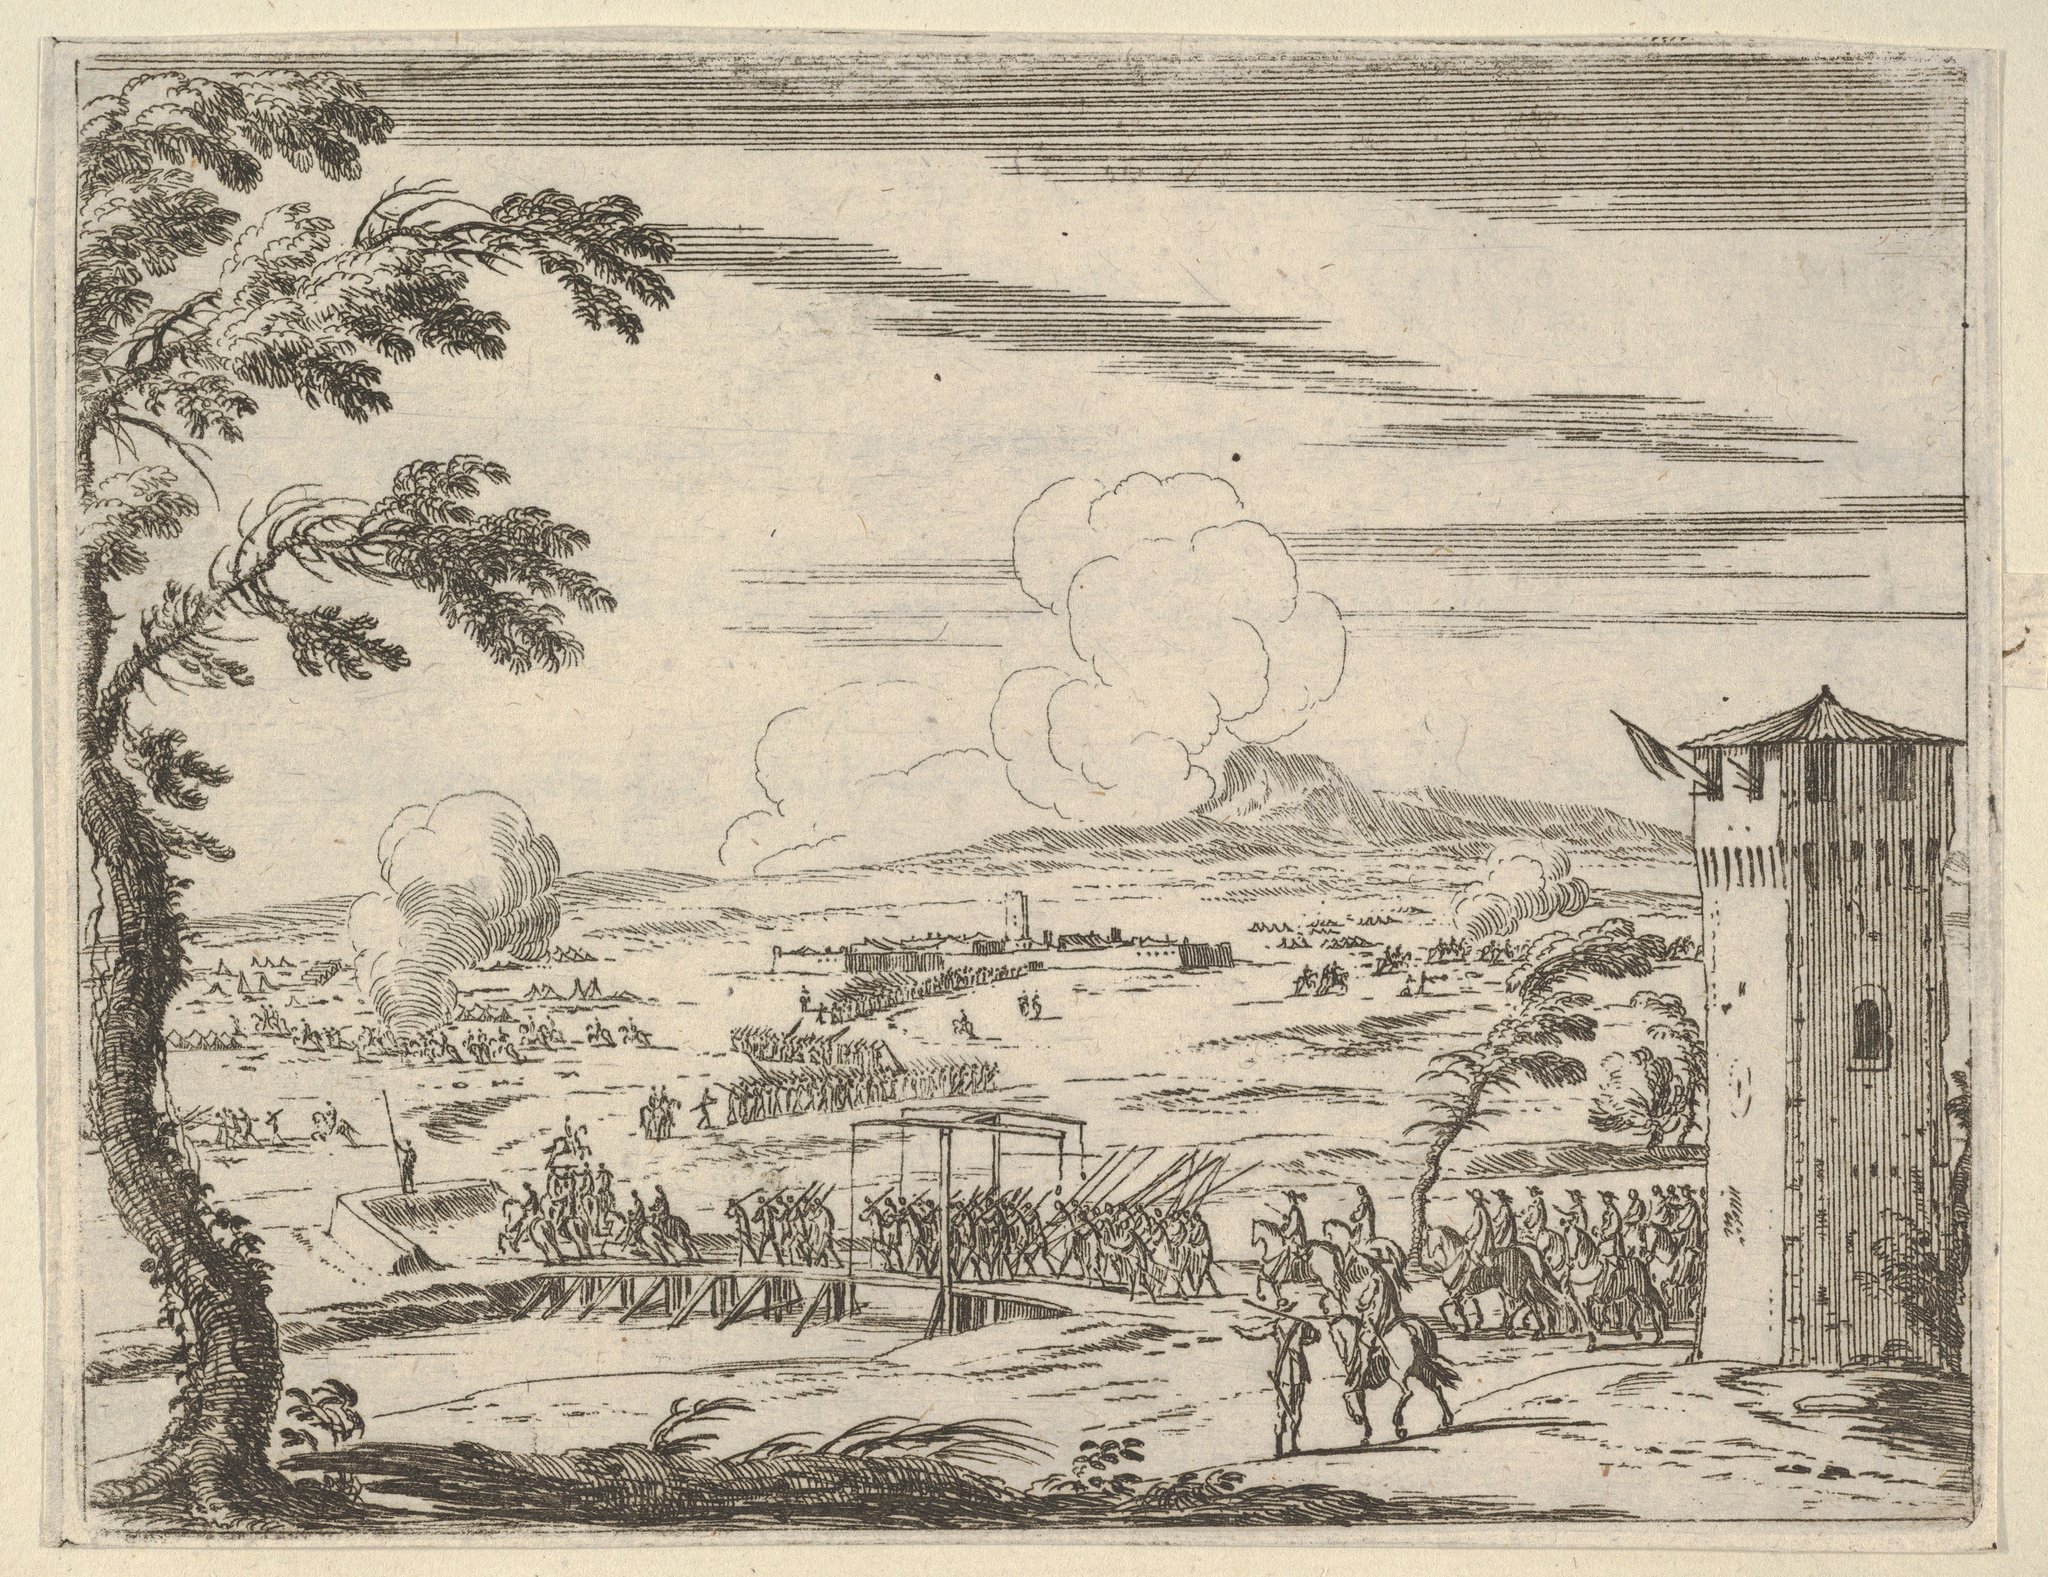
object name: print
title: Francesco I d'Este Protects the Piazza di Nonantola Against the Marchesa Mattei with a Small Number of People and a Great Loss of Ecclesiastics, from "L'Idea di un Principe ed Eroe Cristiano in Francesco I d'Este, di Modena e Reggio Duca VIII [...]"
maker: bartolomeo fenice (fénis)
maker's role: artist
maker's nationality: italian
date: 1659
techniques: etching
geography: italy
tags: towers,battles,soldiers,men,horses,landscapes